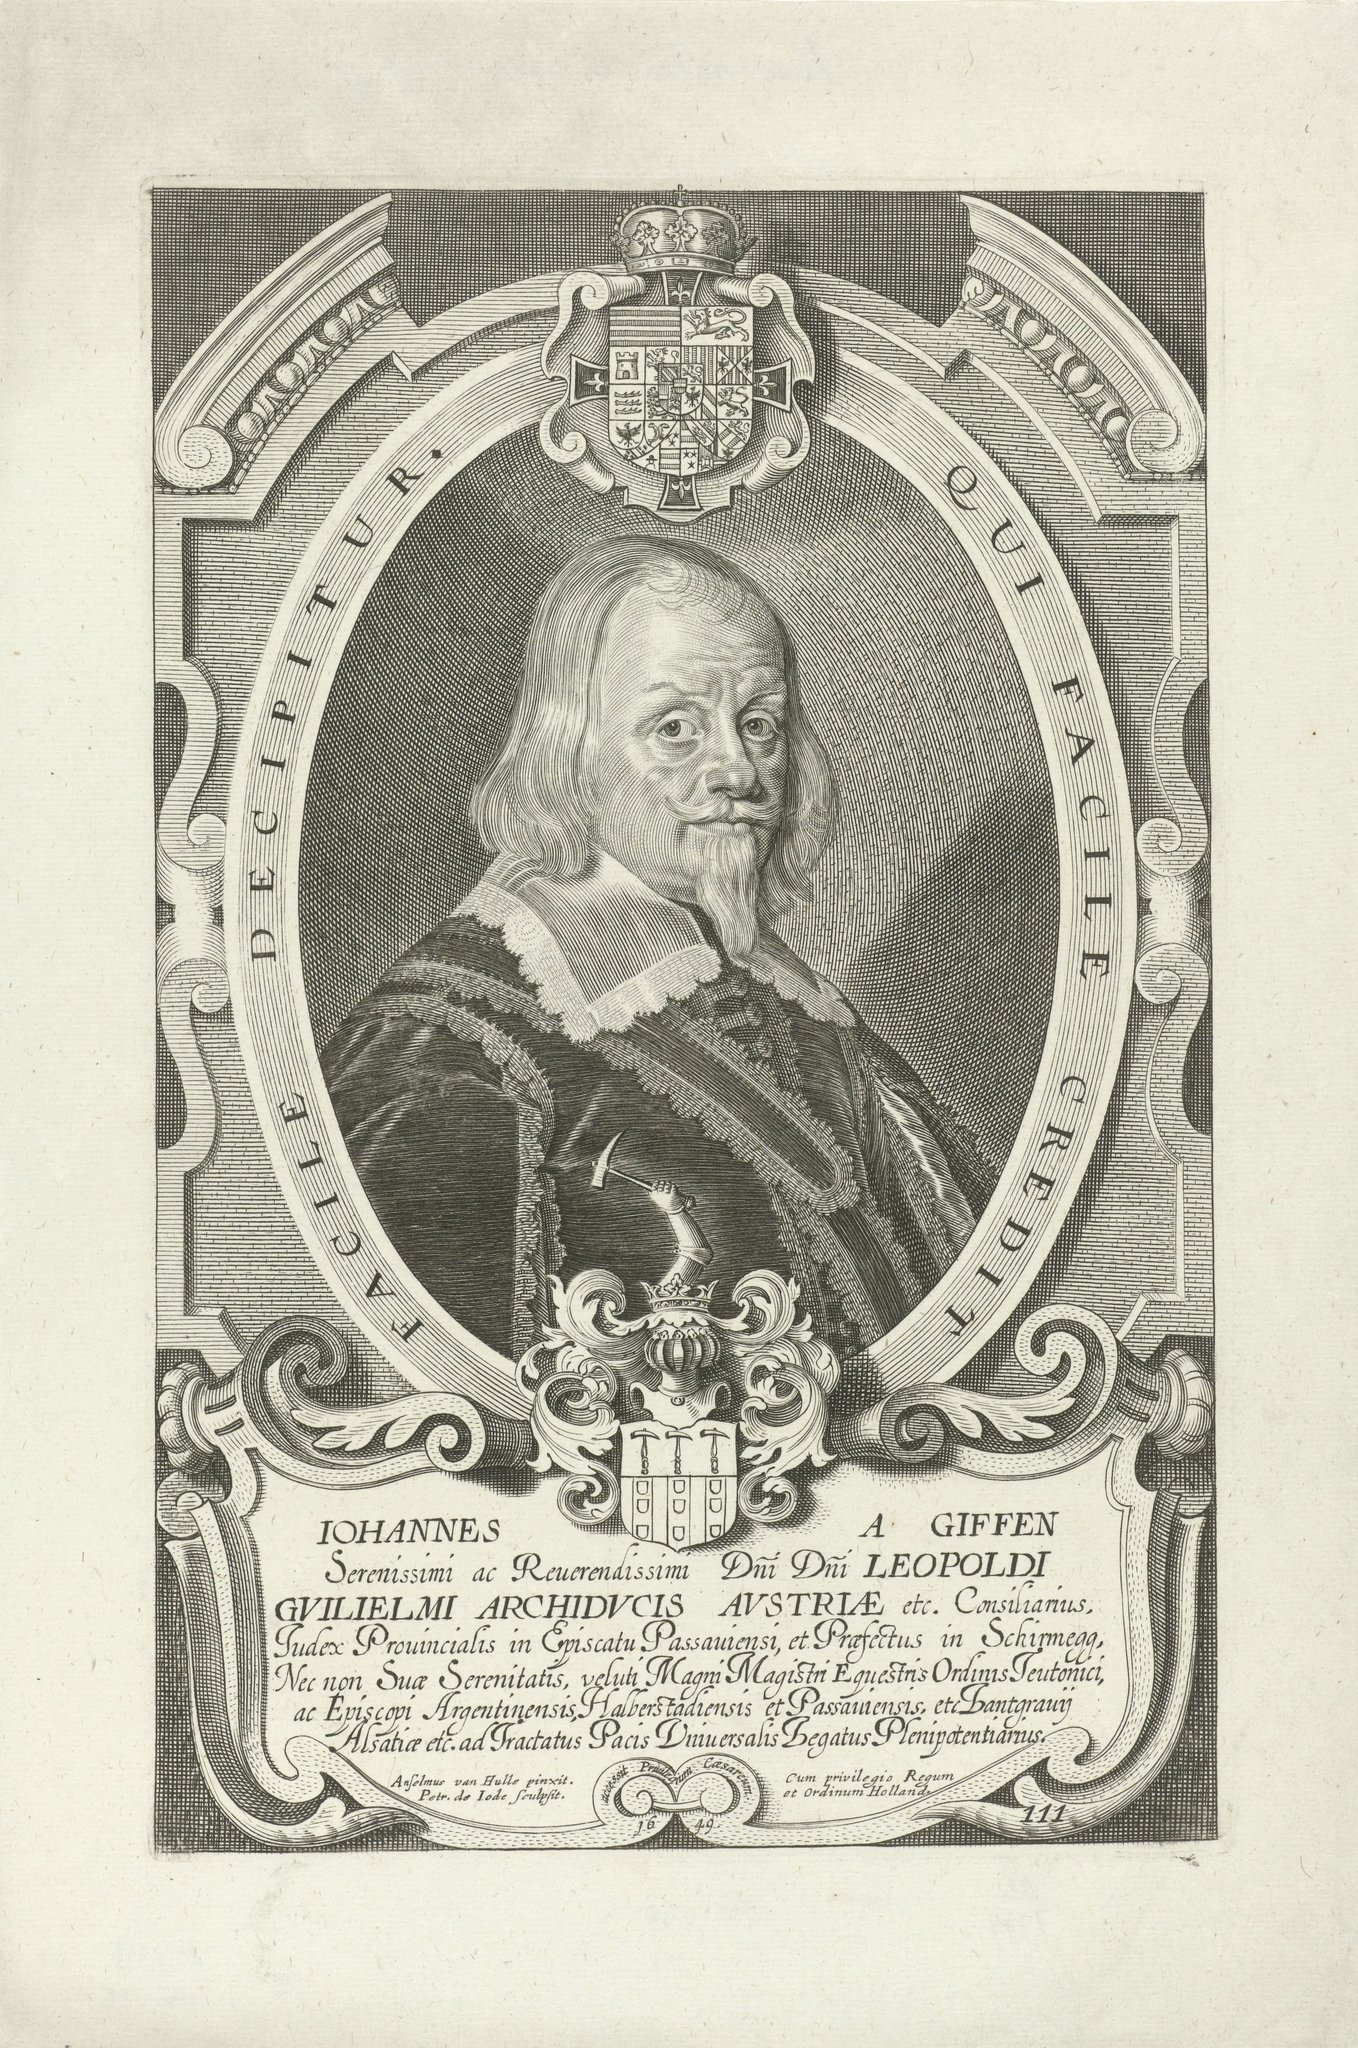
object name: print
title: Hommes illustres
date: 1649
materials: paper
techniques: engraving, etching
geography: antwerp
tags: johann giffen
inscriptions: collector's mark: Lugt 2228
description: Portret van Johann van Giffen. Rechtsonder: 111. Het portret is gevat in een ovale omlijsting met het wapenschild van de geportretteerde en een randschrift in het Latijn. In de cartouche een zevenregelig onderschrift in het Latijn. Prent uit een serie portretten naar schilderijen van Anselmus van Hulle van alle gedelegeerden bij de vredesonderhandelingen te Münster en Osnabrück.